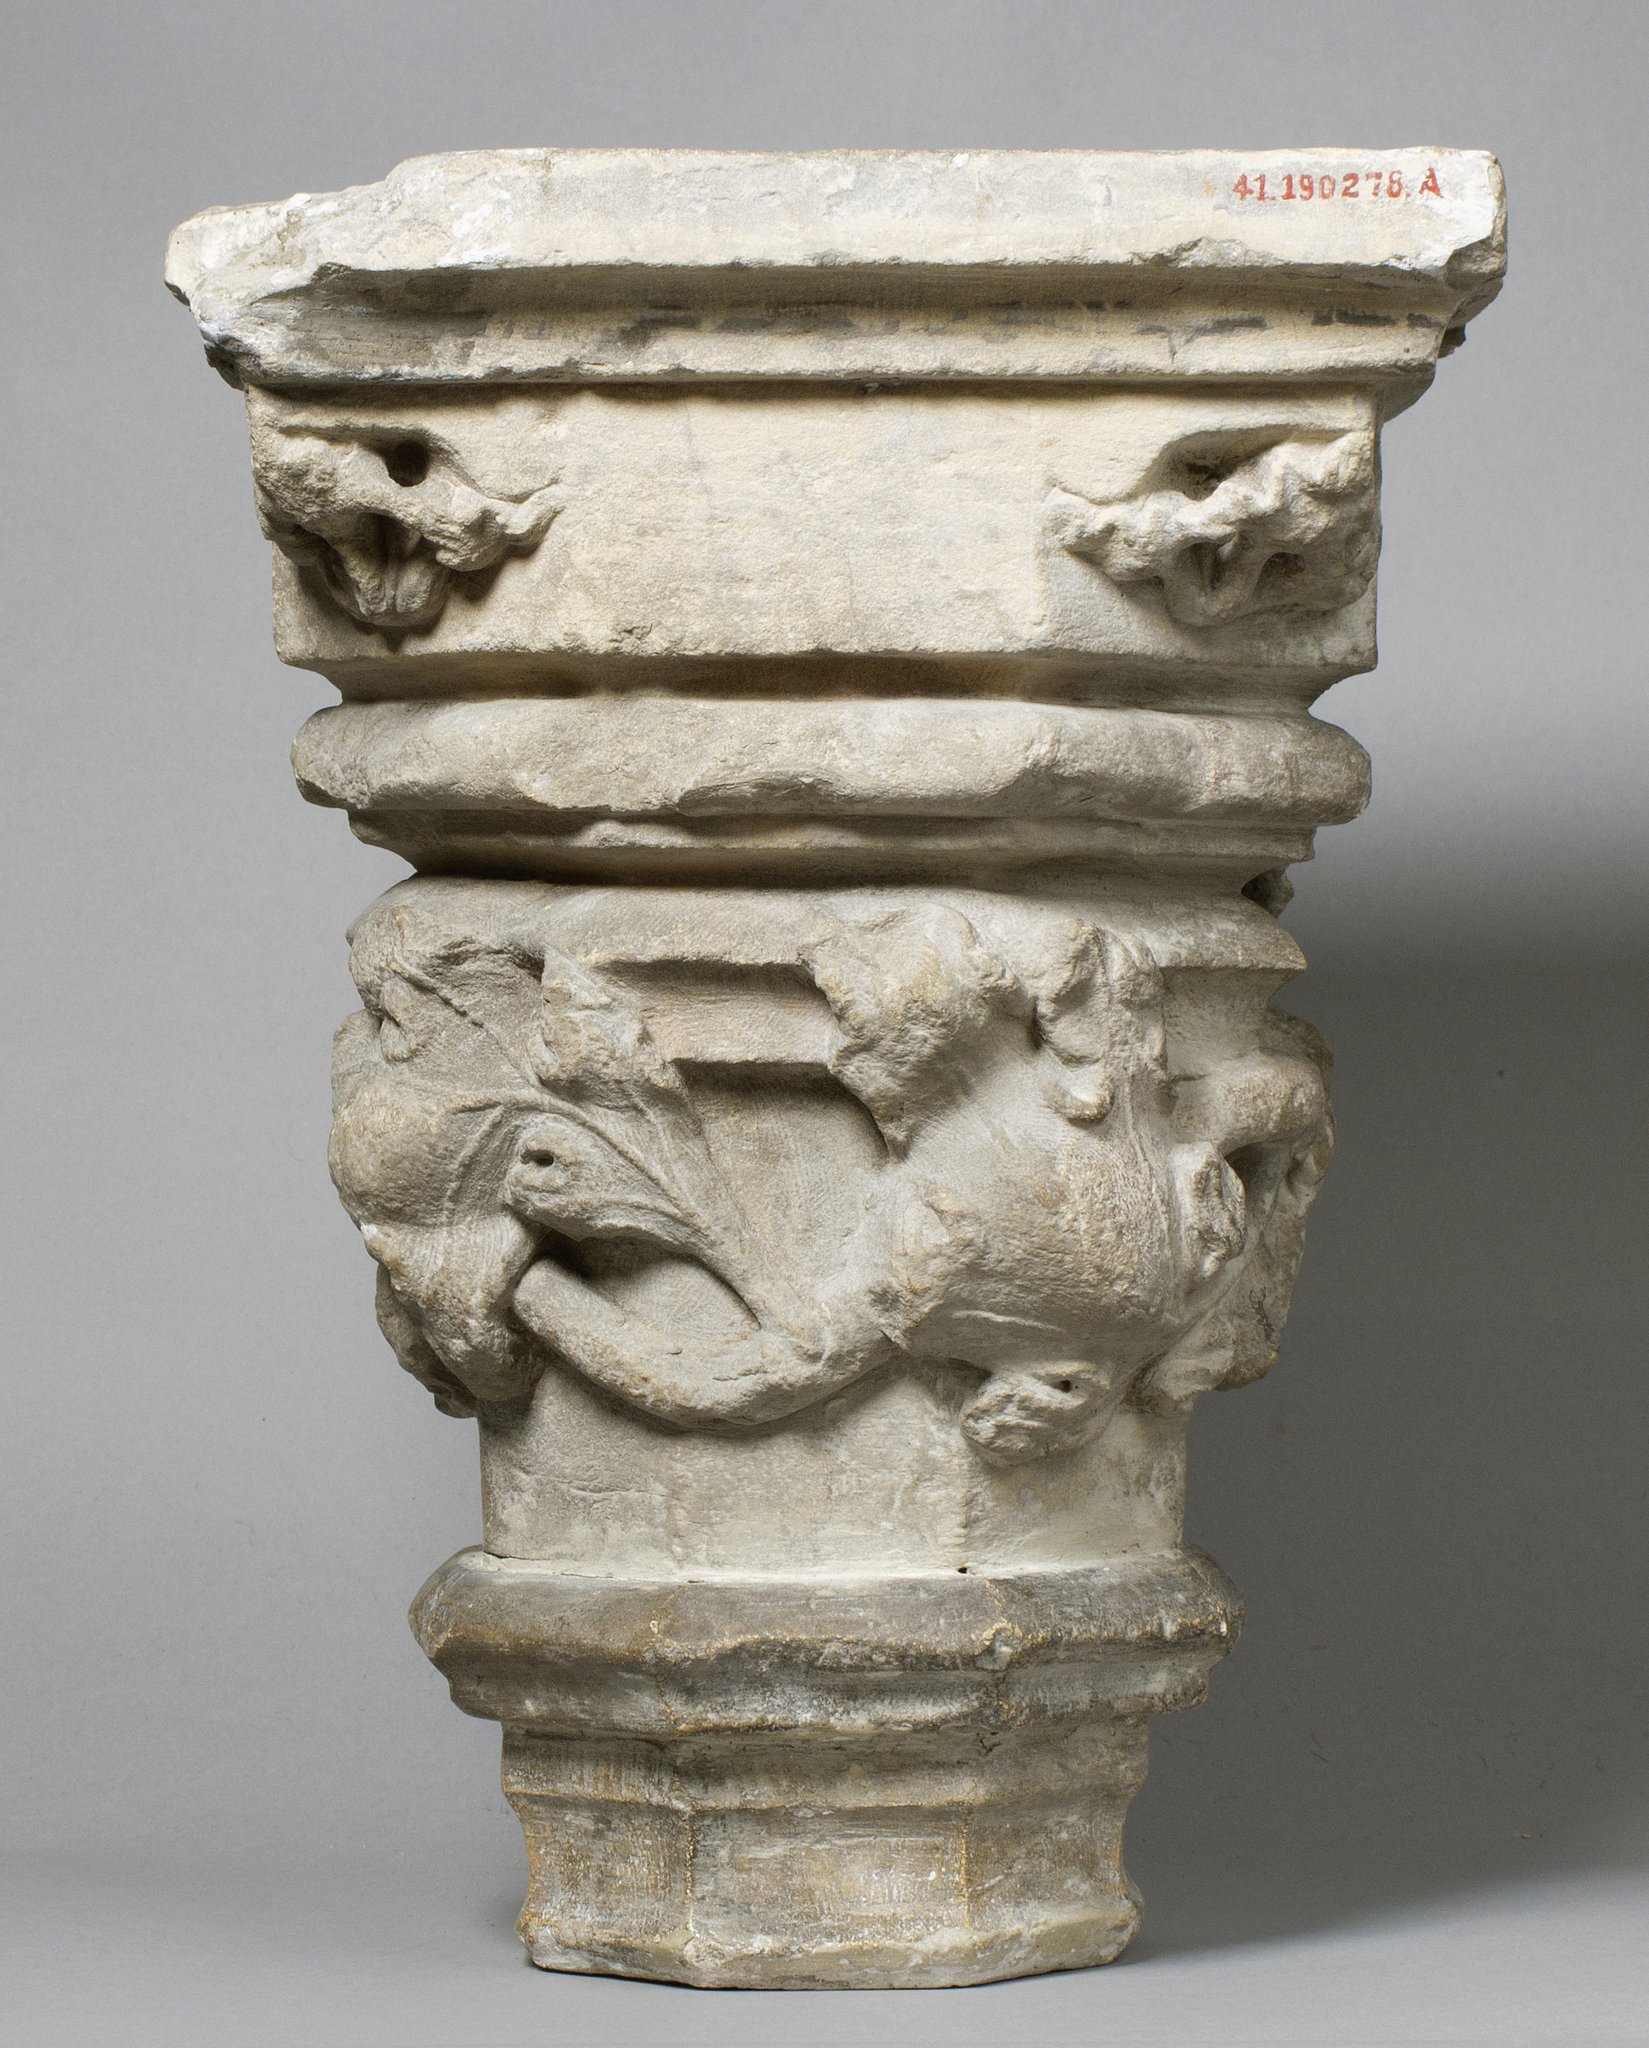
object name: capital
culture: french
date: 1401-1500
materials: stone